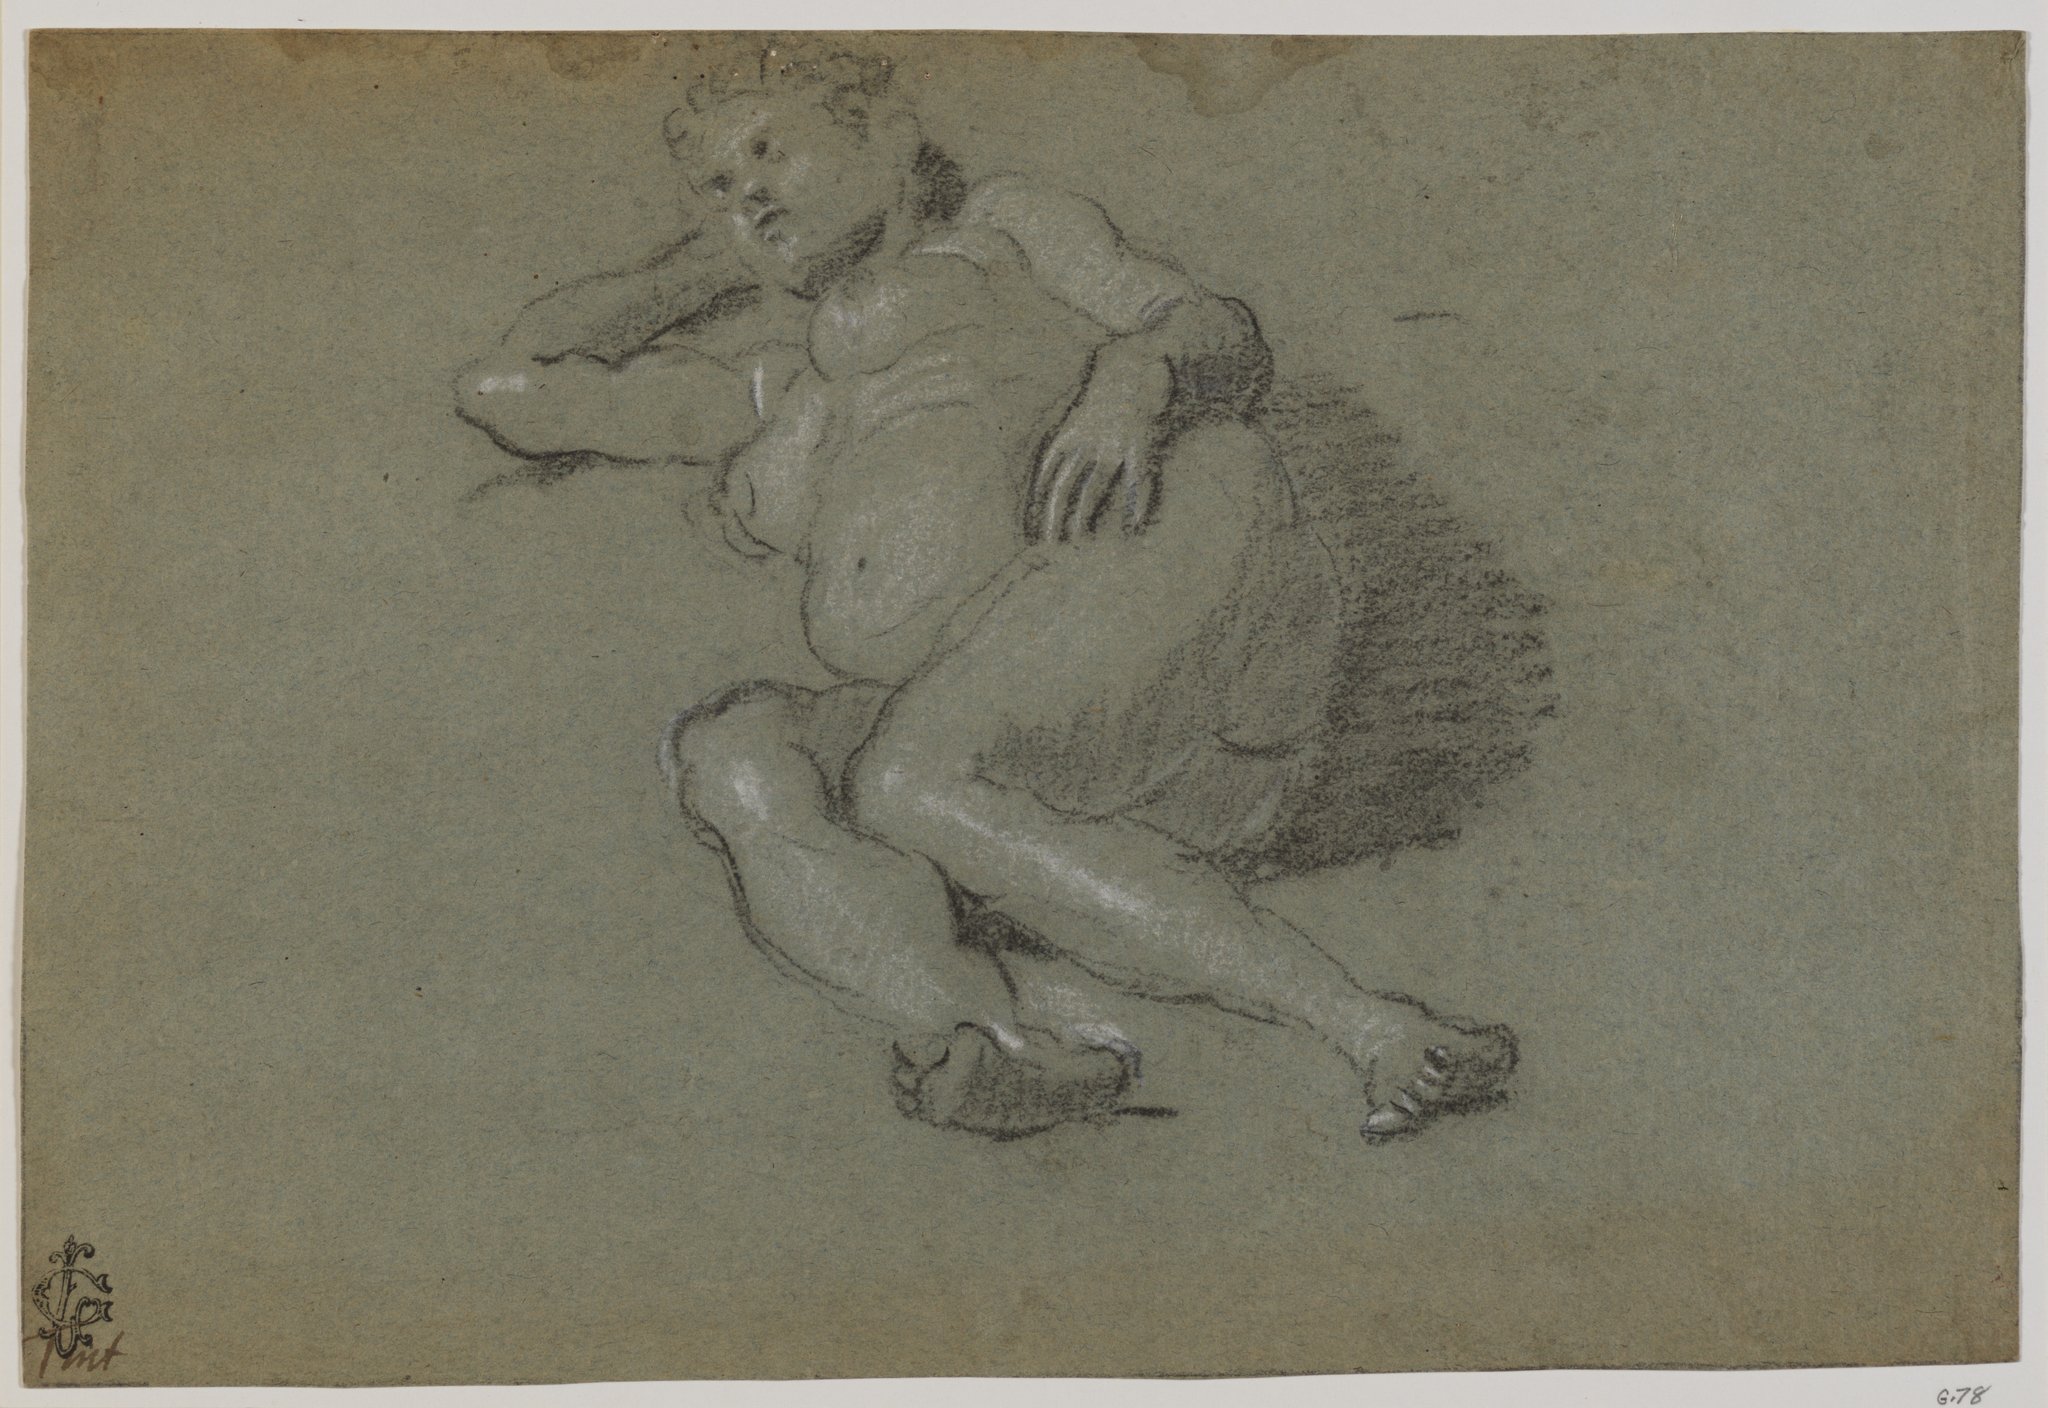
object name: drawing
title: Reclining Female Nude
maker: domenico tintoretto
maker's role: artist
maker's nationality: italian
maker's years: 1560-1635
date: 1601-1633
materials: chalk, paper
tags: female nudes